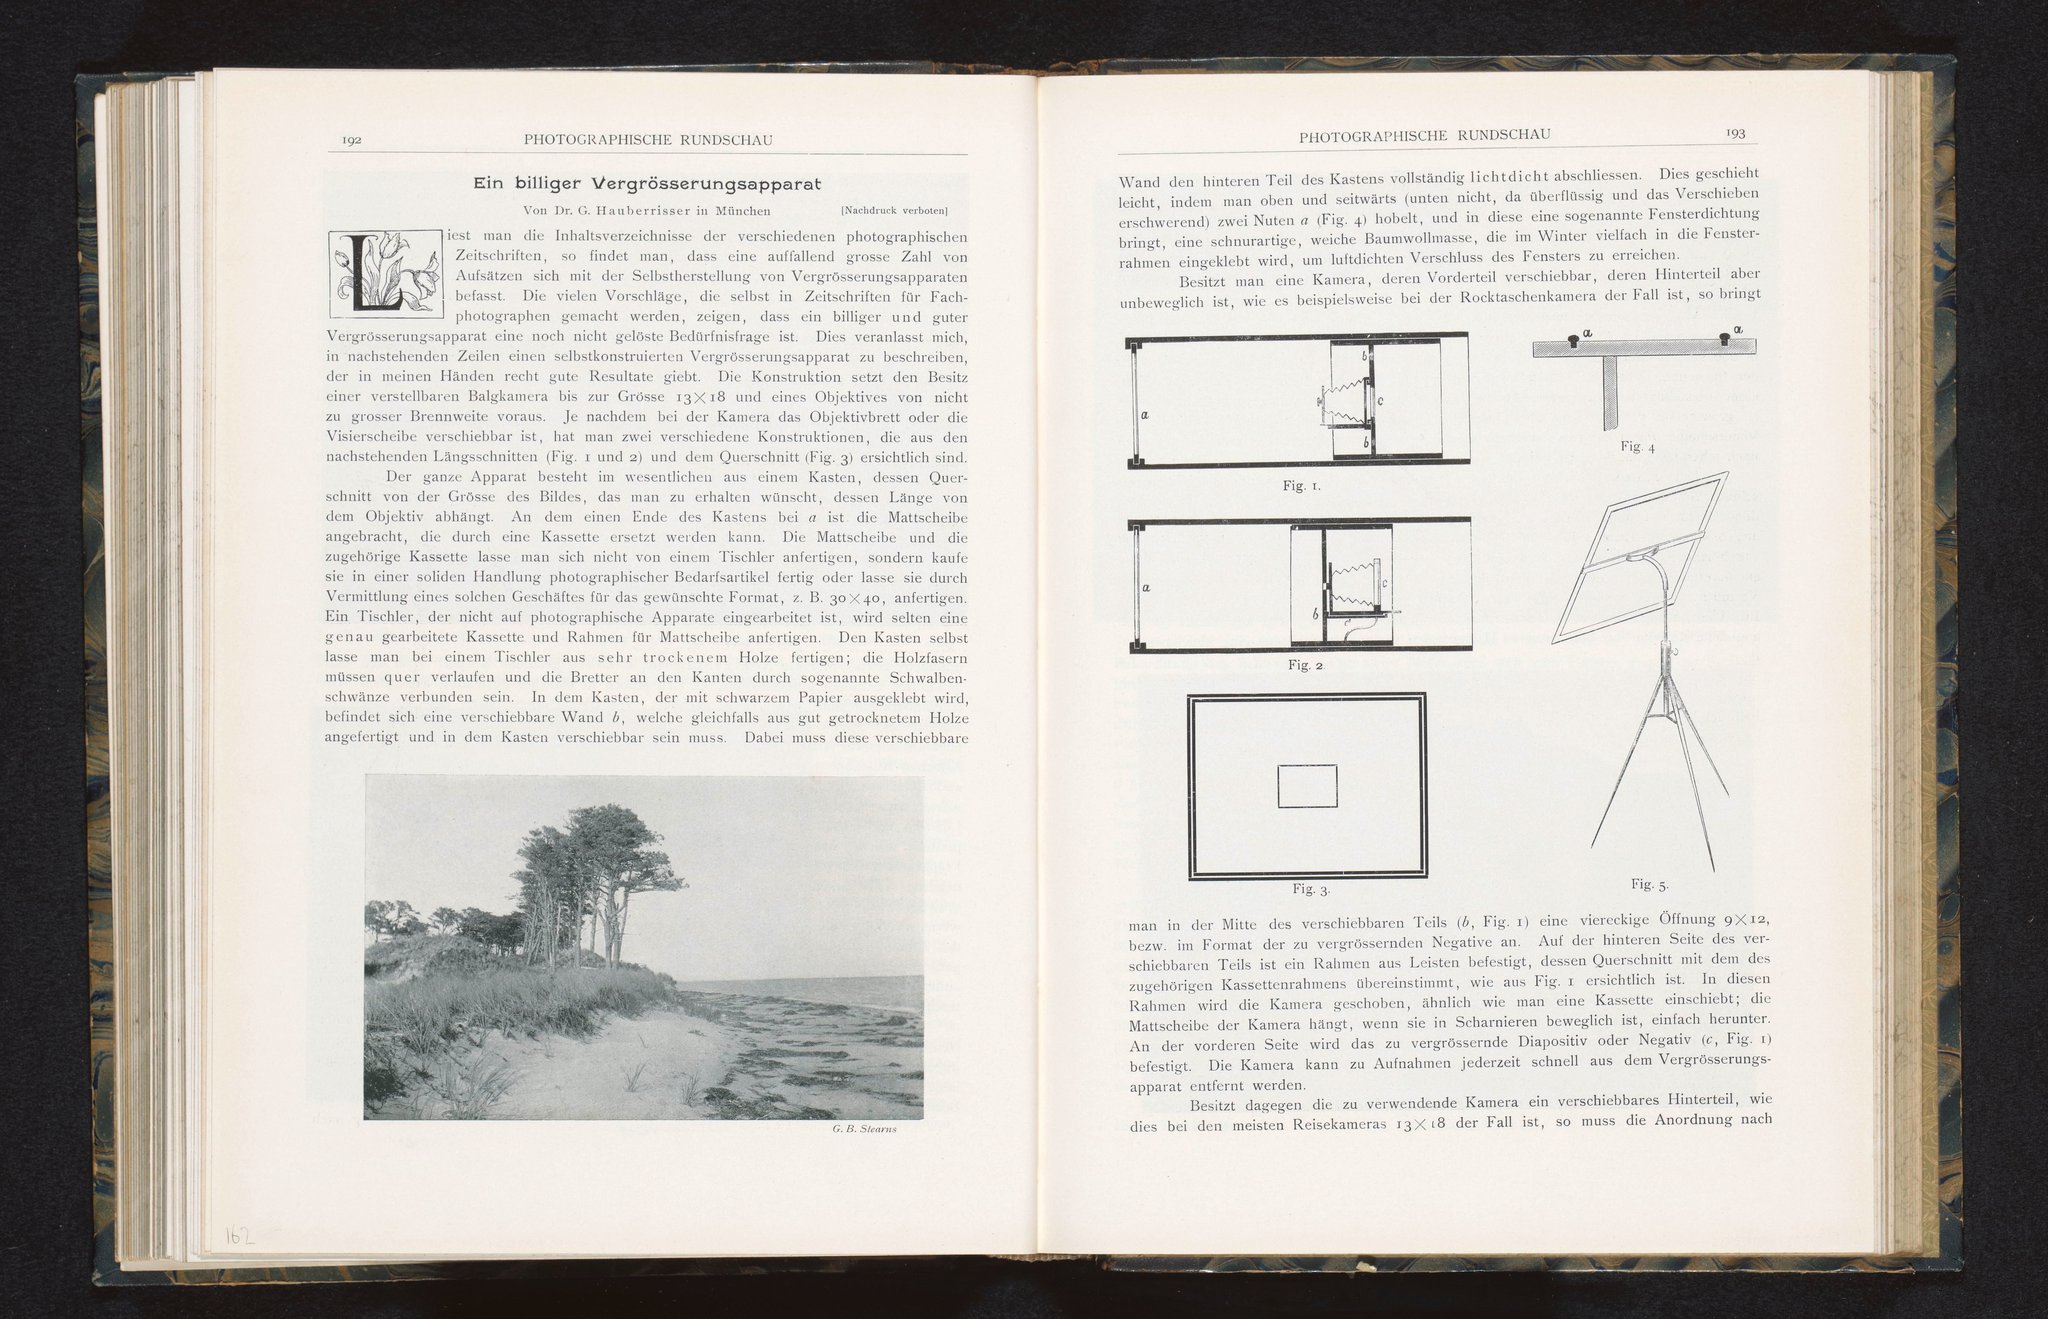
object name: page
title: Gezicht op een landschap met enkele bomen aan het water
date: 1895-1900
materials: paper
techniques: autotype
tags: trees, landscapes with waters, waterscapes, seascapes (in the temperate zone)